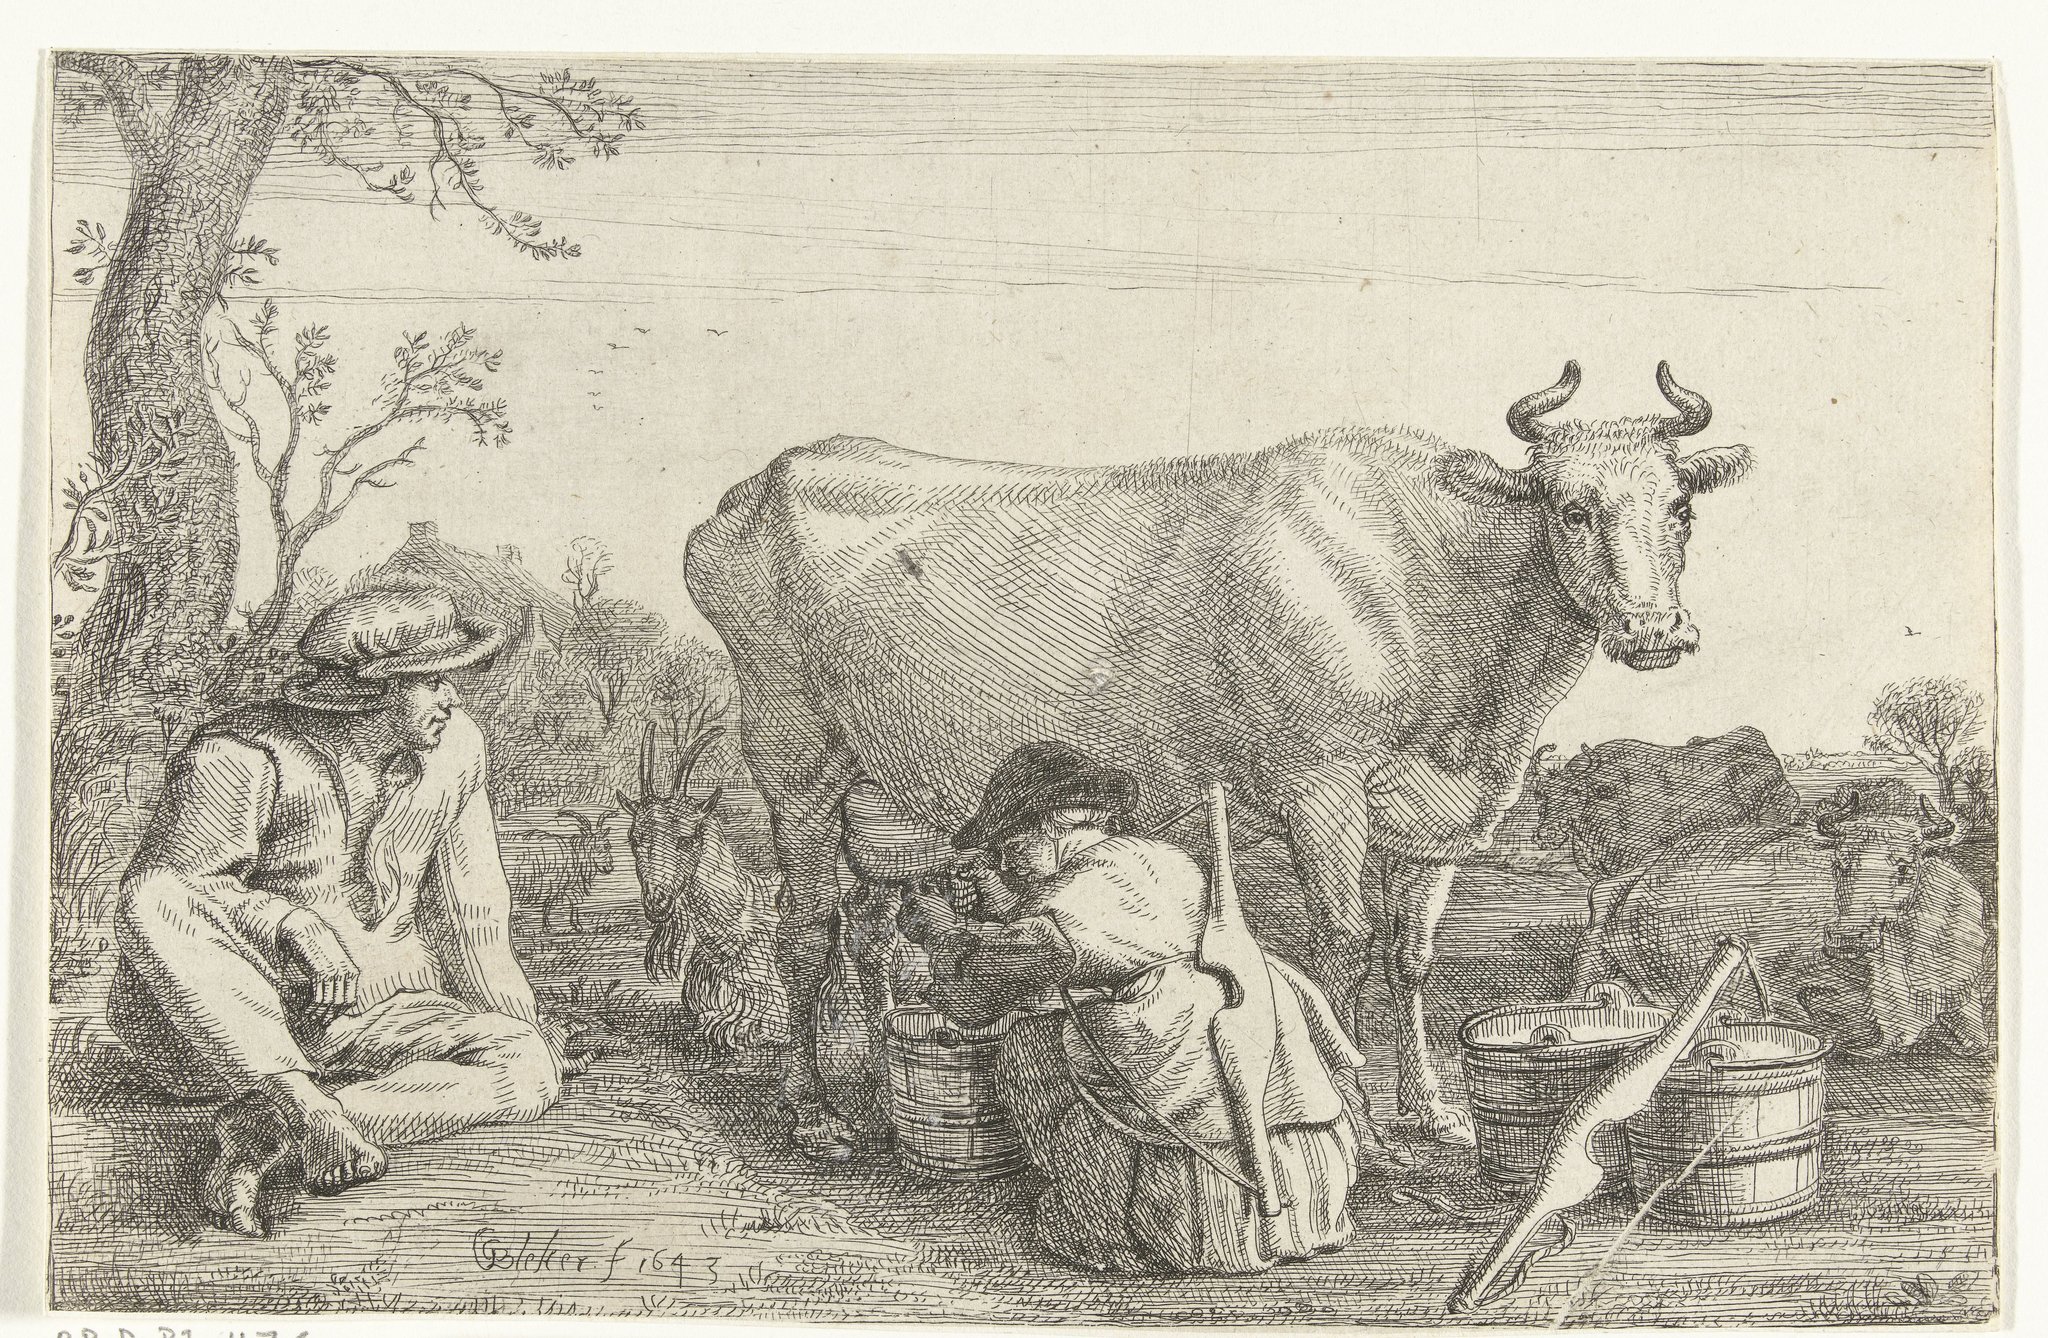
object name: print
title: Melkmeid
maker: gerrit bleker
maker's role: print maker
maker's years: -1656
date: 1643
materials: paper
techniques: etching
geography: haarlem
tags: cow, milkmaid, amorousness, desire, yoke, milking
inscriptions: collector's mark: Lugt 2228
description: Een herderin melkt een koe, naast haar onder een boom zit een herder uit te rusten en naar haar te kijken. Op de grond ligt een juk en staan melkemmers.